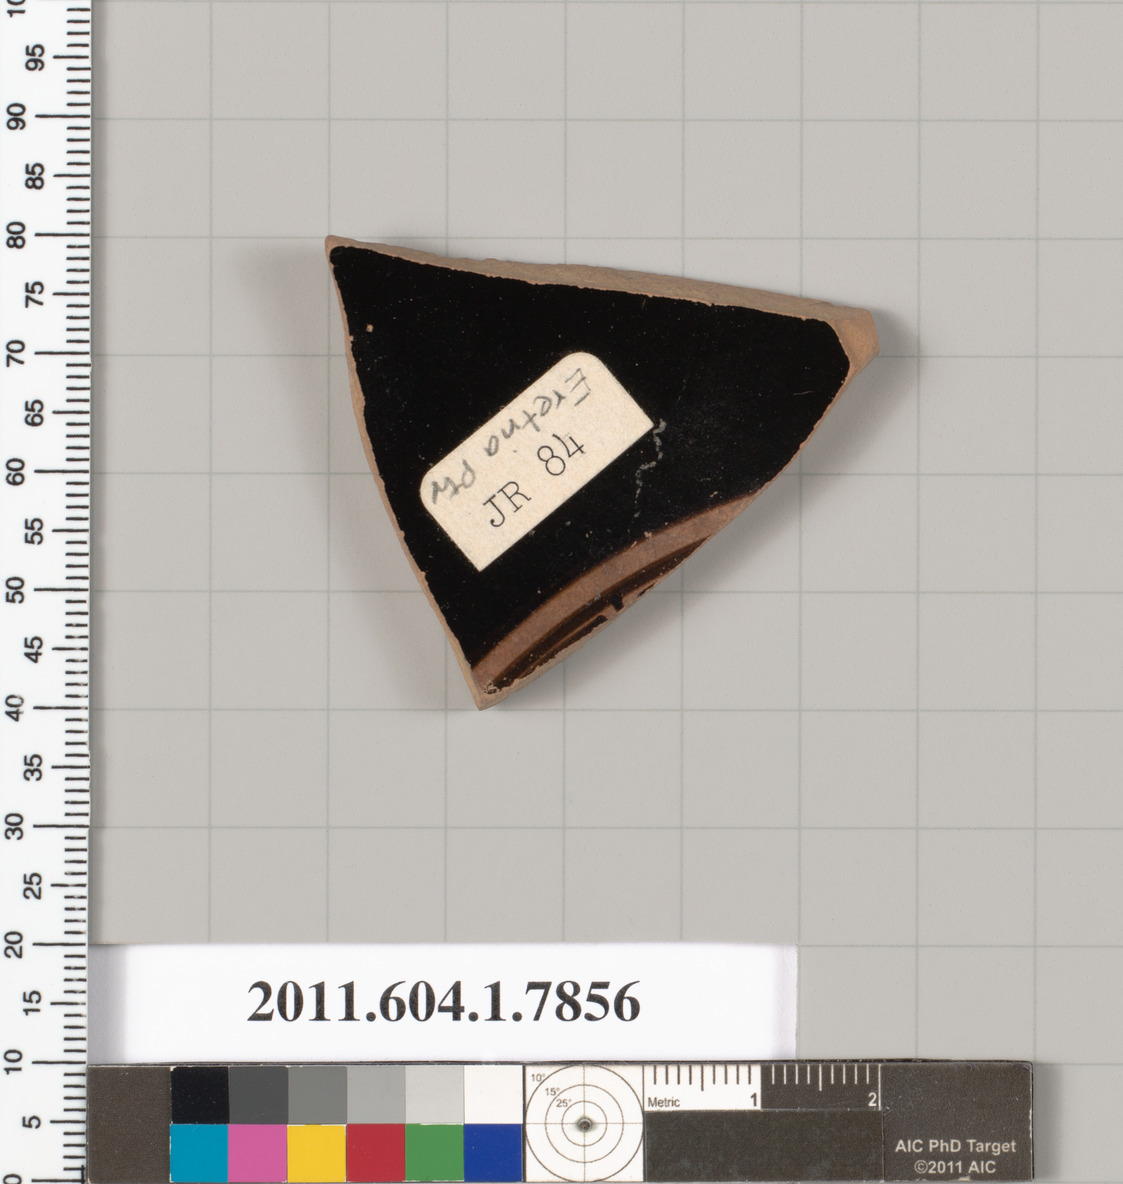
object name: kylix fragment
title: Terracotta fragment of a kylix (drinking cup)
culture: greek, attic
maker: eretria painter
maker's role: artist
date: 450-426 BCE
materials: terracotta